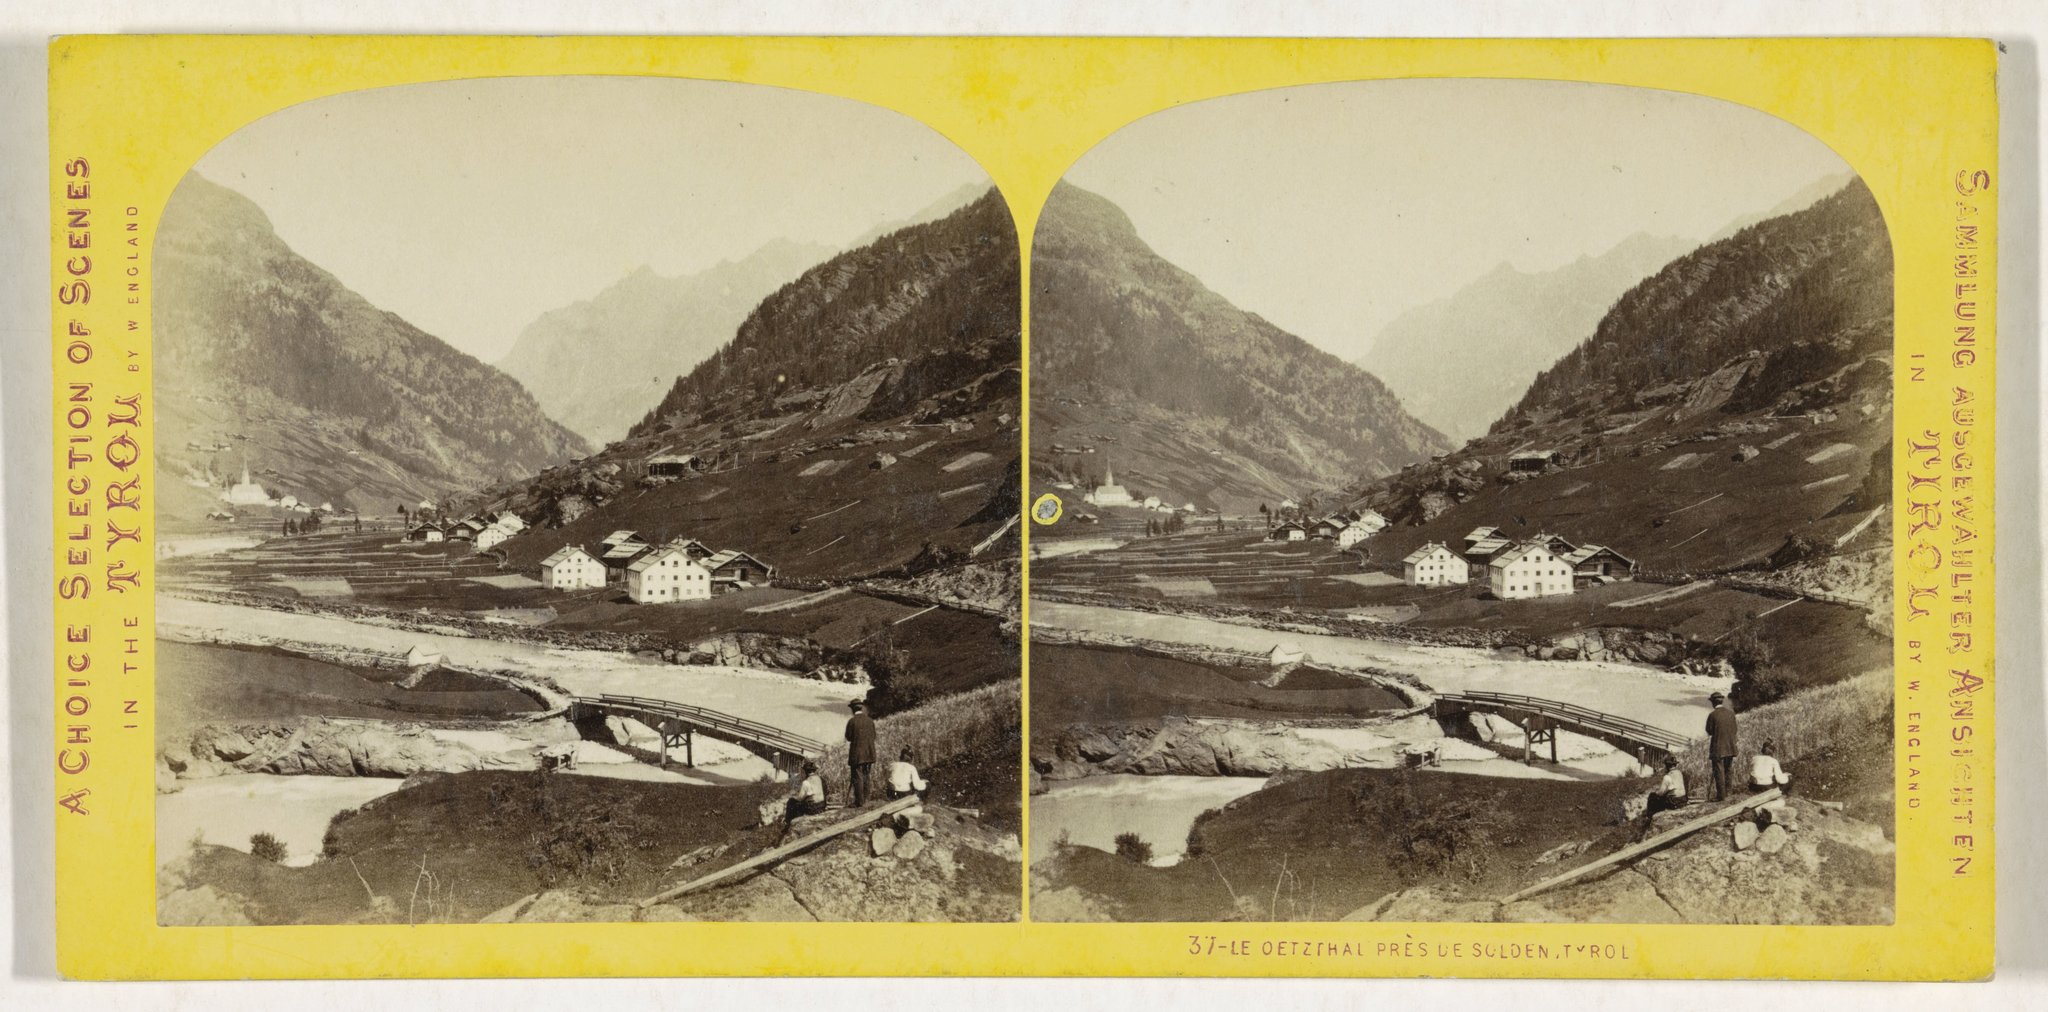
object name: stereograph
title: Gezicht op het Ötztal nabij Sölden, Oostenrijk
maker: william england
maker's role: fotograaf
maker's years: 1816-1896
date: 1863-1865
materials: cardboard, paper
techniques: albumen print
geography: ötztal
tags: mountain meadow, alp, mountains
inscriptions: number: ‘37’